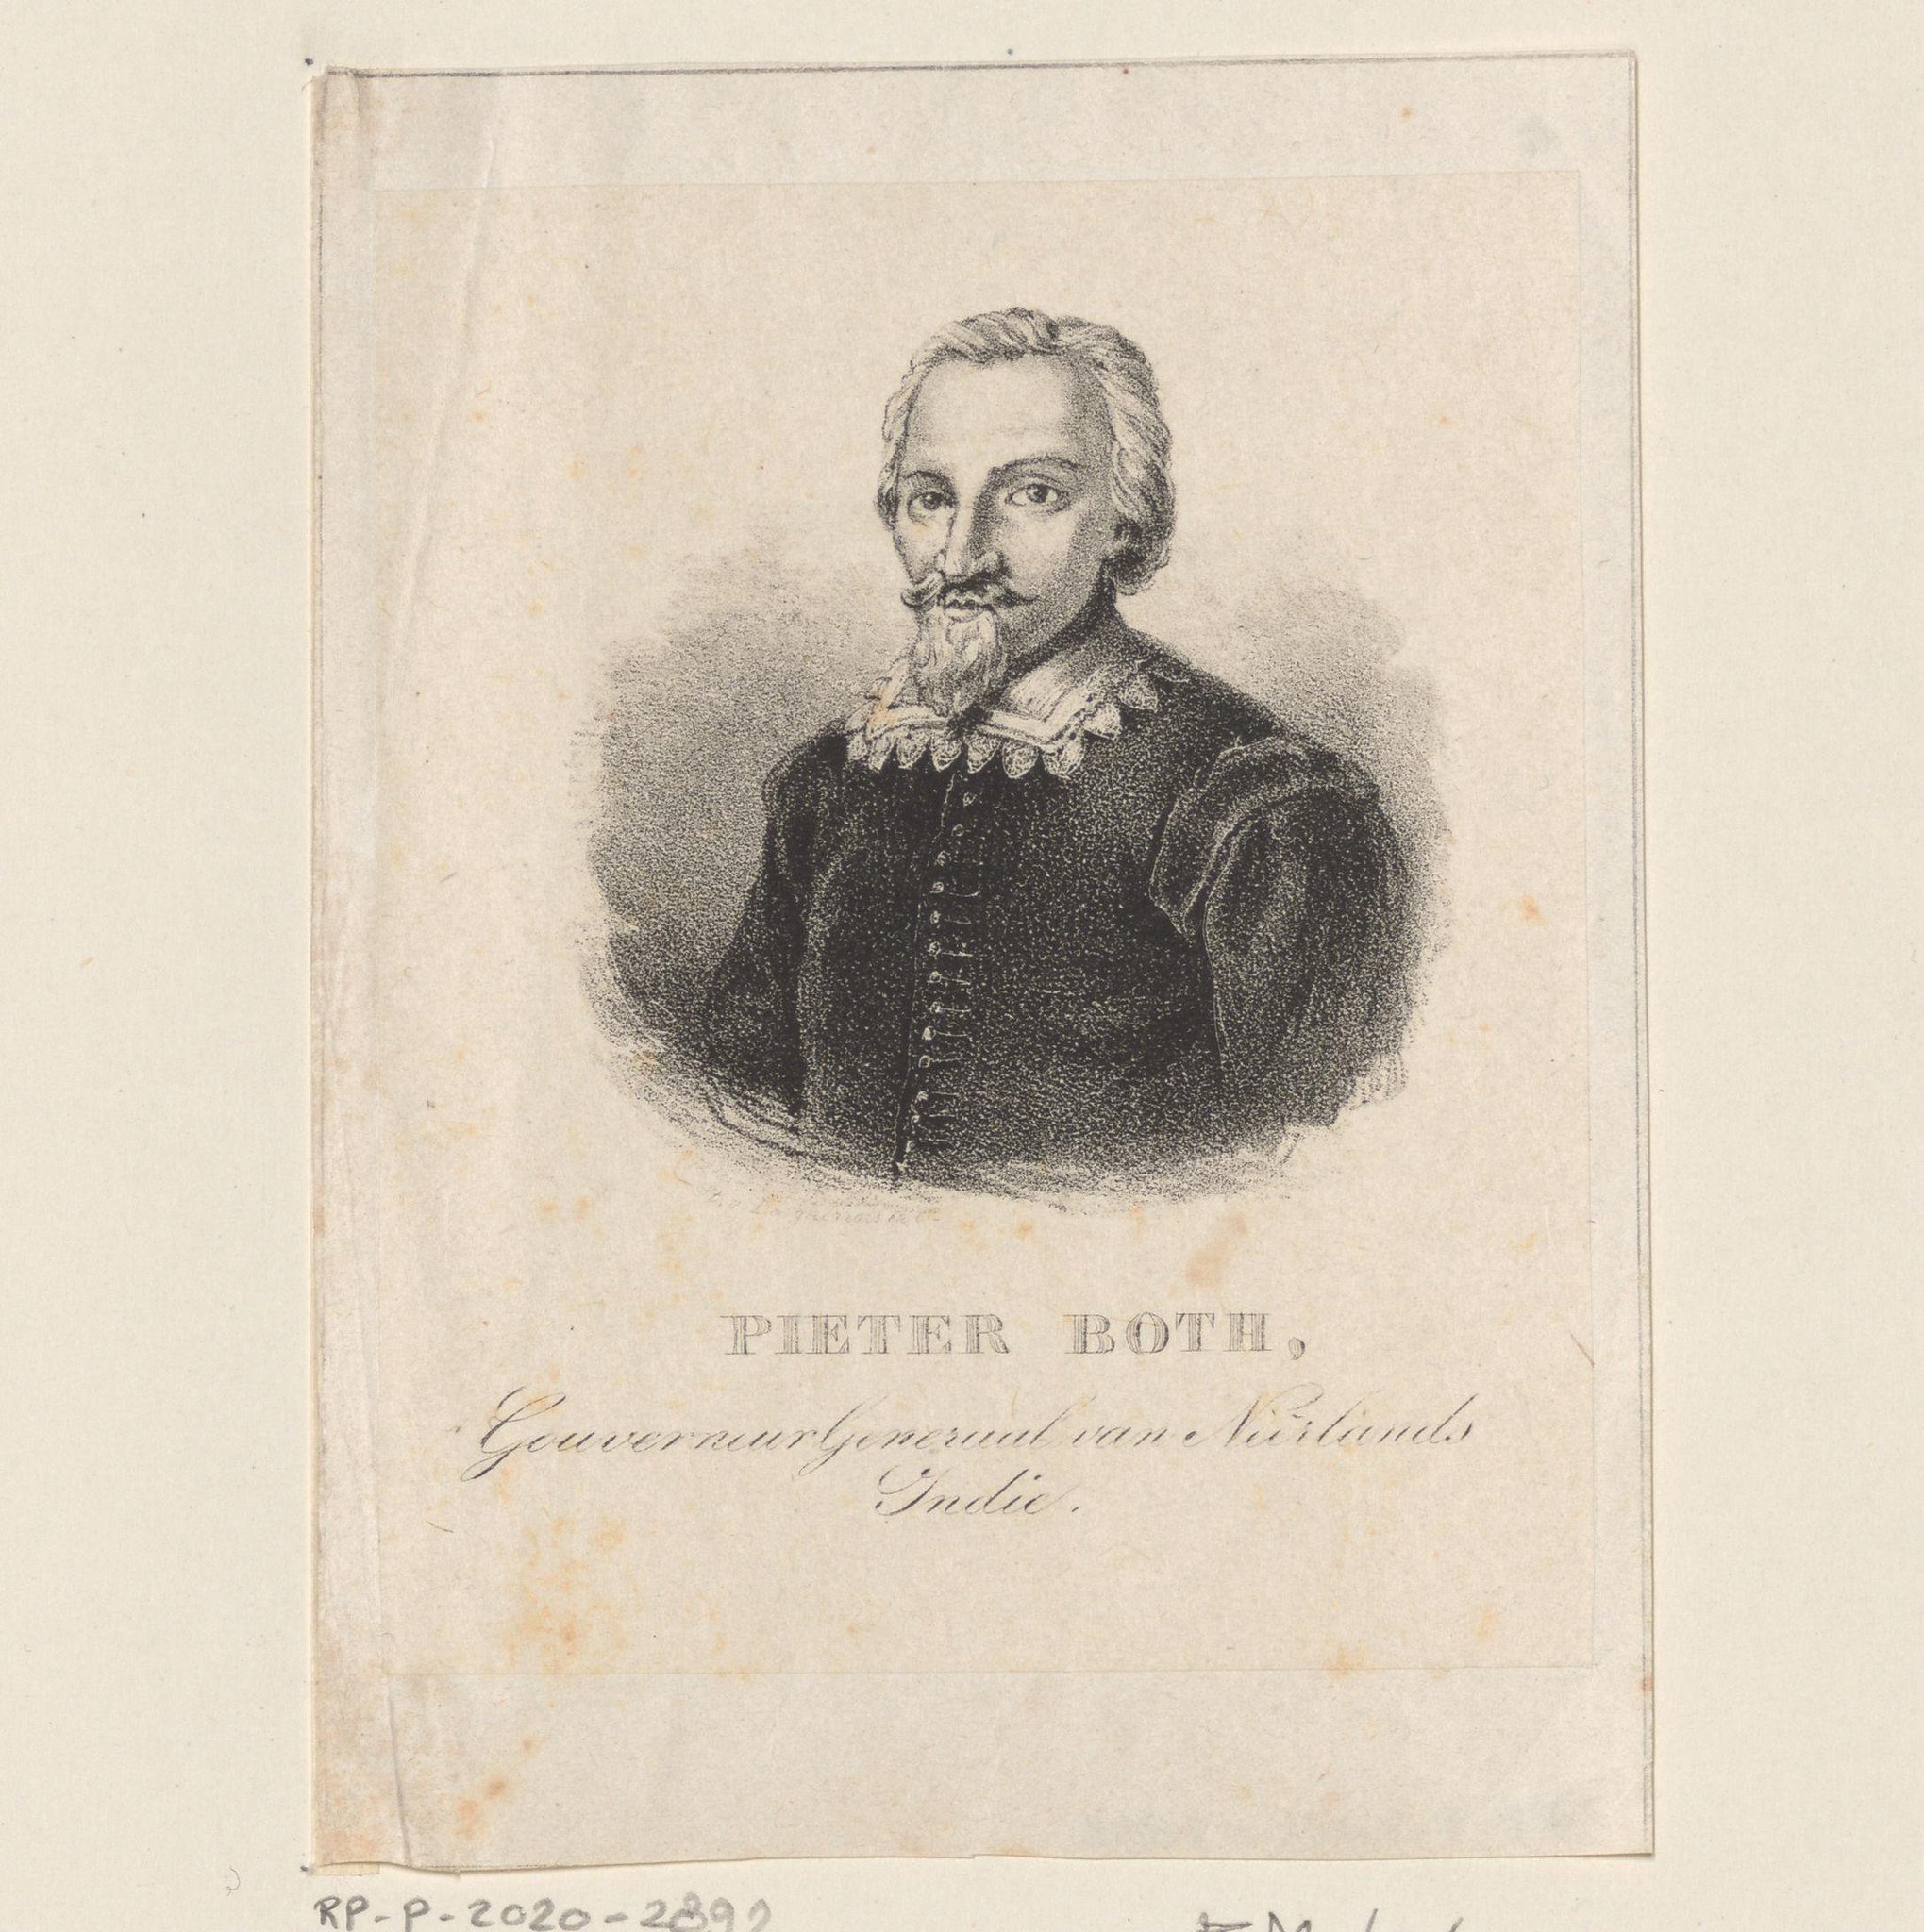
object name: print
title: Portret van Pieter Both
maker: Anonymous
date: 1827-1899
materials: paper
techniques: lithograph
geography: amsterdam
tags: colonial governor, historical persons